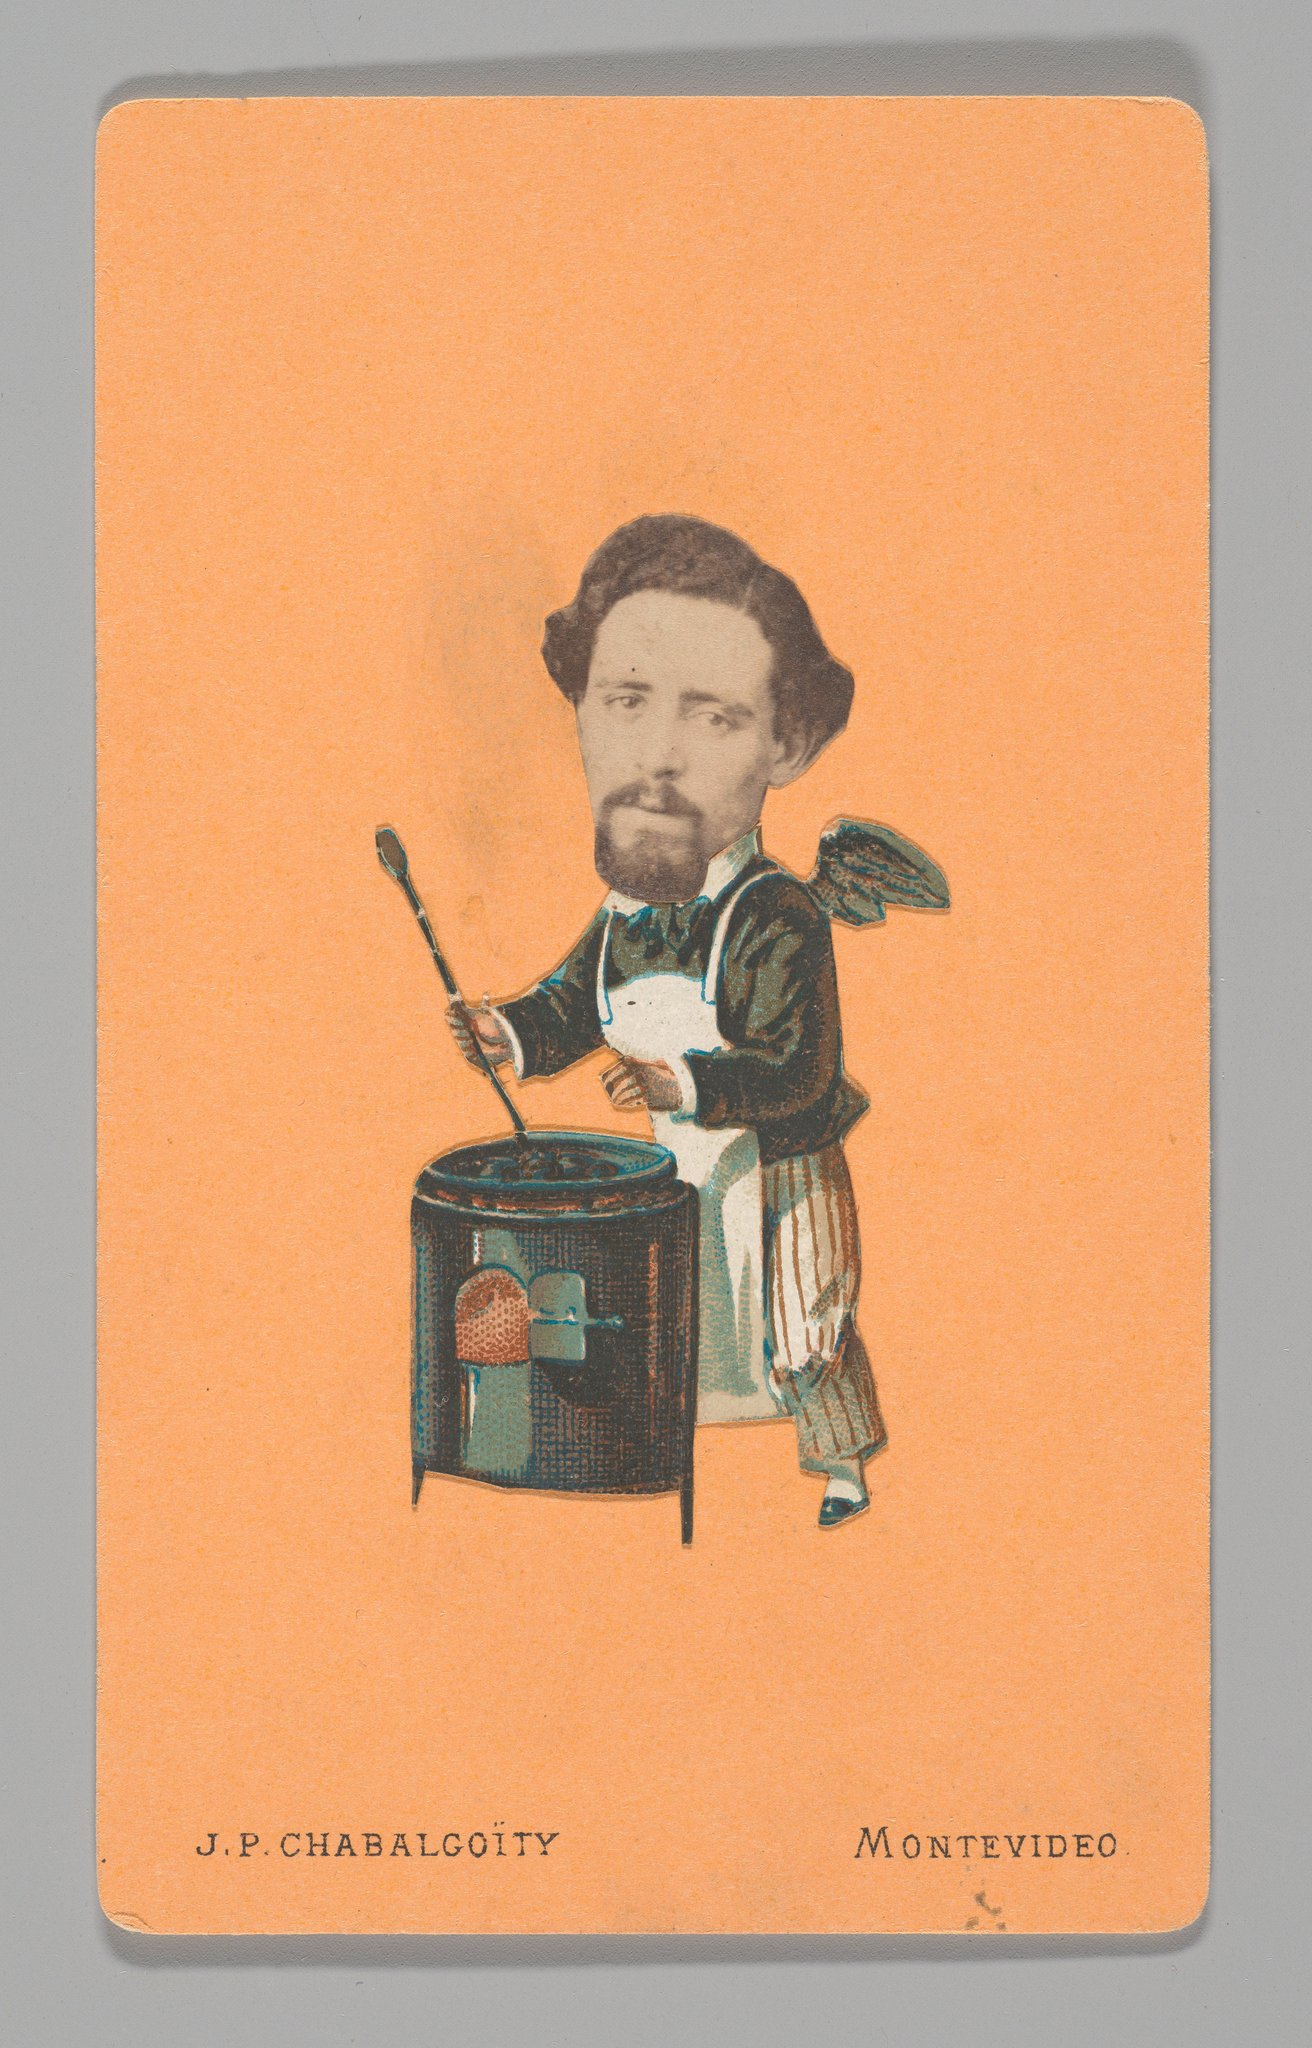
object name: carte de visite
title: [Photo Collage: Cook at Charcoal Stove]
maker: juan pedro chabalgoity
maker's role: artist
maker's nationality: uruguayan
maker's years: 1848-1909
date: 1875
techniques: albumen silver print, lithograph